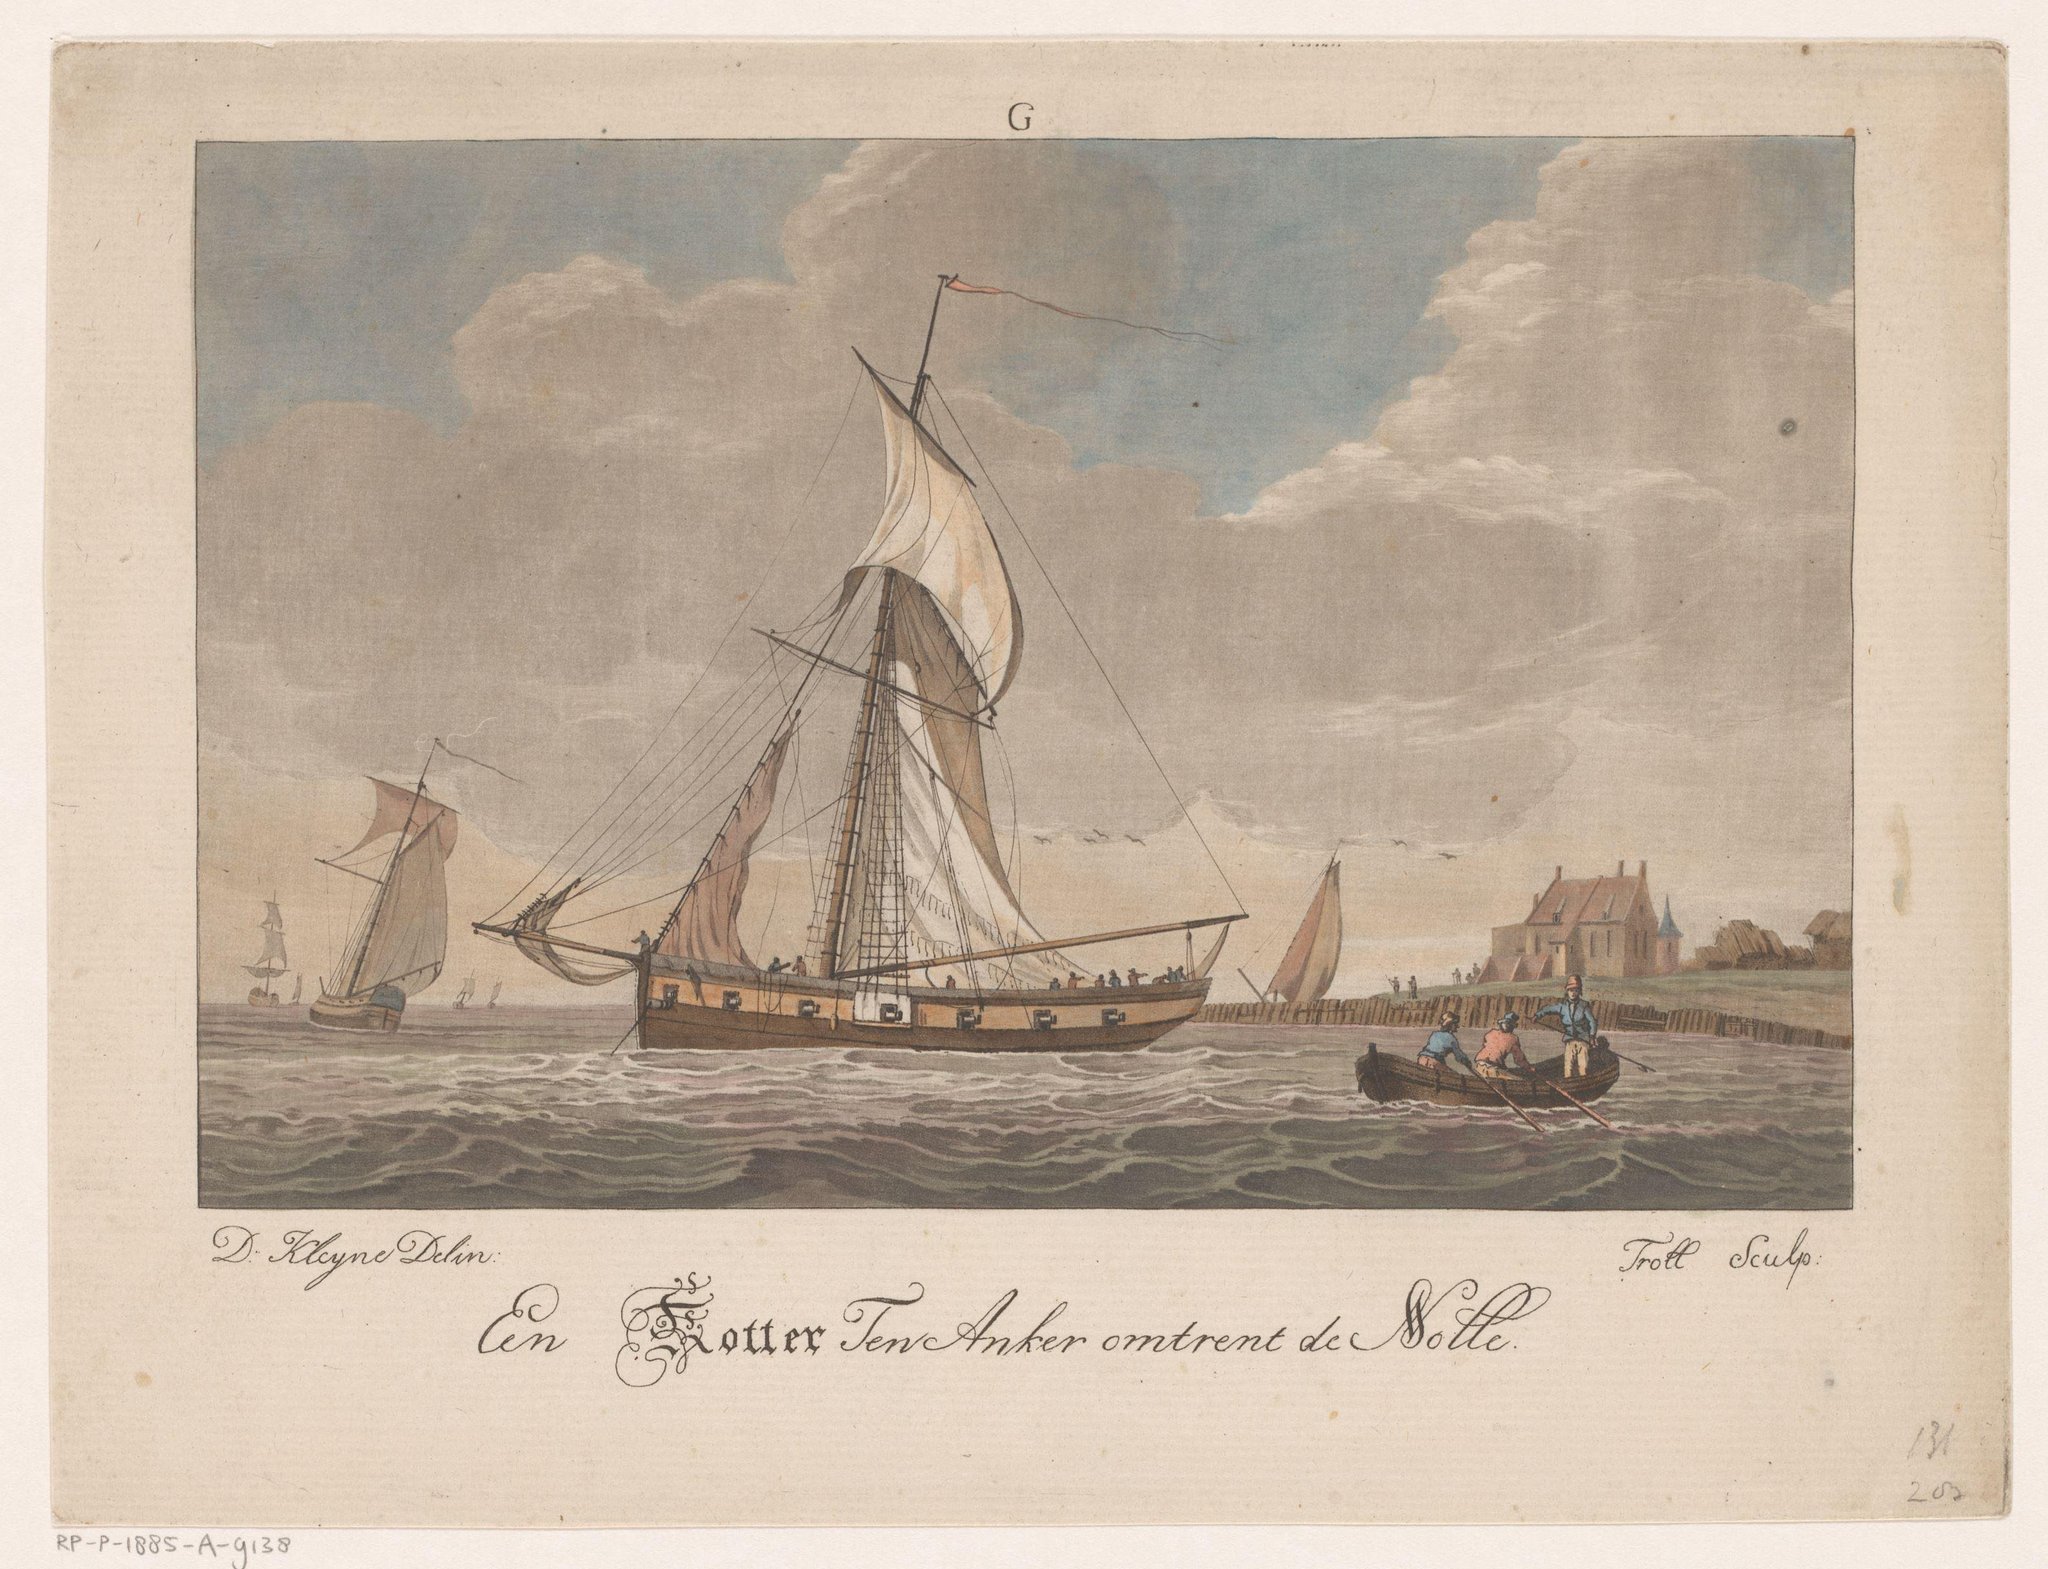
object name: print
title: Een Kotter Ten Anker omtrent de Nolle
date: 1766-1824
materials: paper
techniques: aquatint, etching, lithography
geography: netherlands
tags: sailing-ship, sailing-boat, landscapes with waters, waterscapes, seascapes (in the temperate zone), rowing-boat, canoe, etc.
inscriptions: collector's mark: Lugt 2228